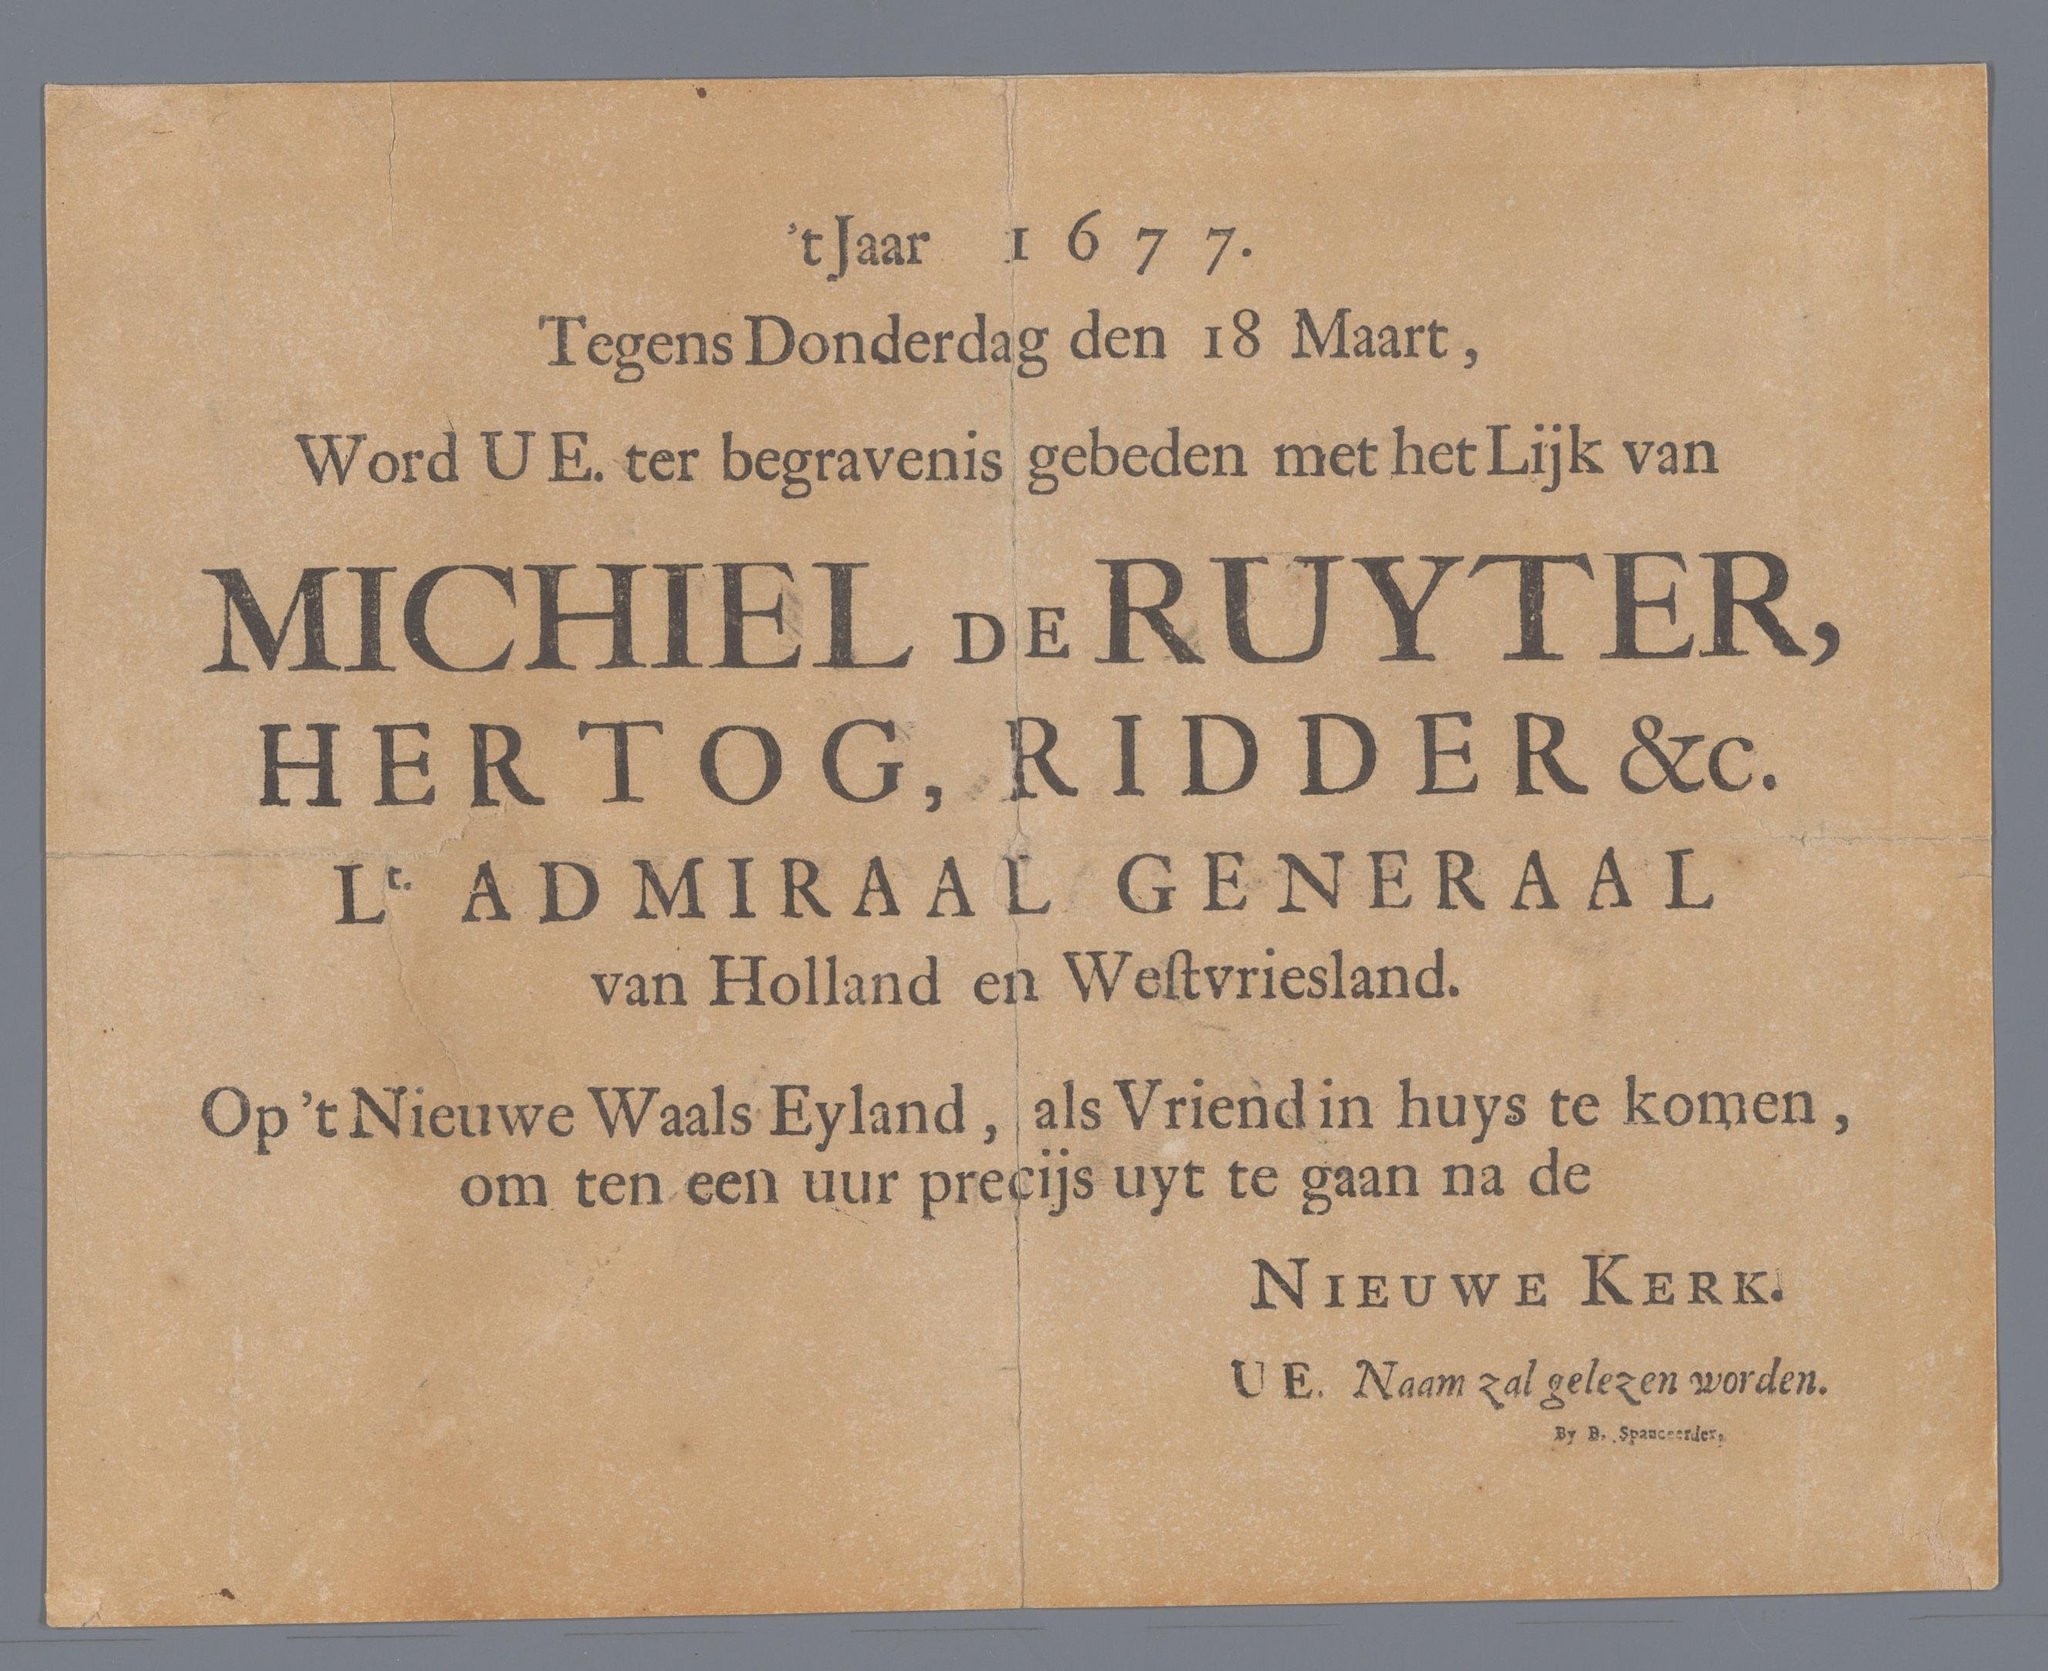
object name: letter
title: Invitation to the funeral of Michiel de Ruyter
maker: bruno spanceerder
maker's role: publisher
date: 1677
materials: paper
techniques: printing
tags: flushing, michiel adriaenszoon de ruyter, amsterdam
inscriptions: signature: ‘By B. Spanceerder’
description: The funeral of Admiral de Ruyter, which took place on 18 March 1677 in the Nieuwe Kerk in Amsterdam, was an imposing event that drew many spectators. A select company was invited to the actual ceremony, which lasted several hours. An even smaller group was permitted to visit the naval hero’s family after the ceremony, also by special invitation.